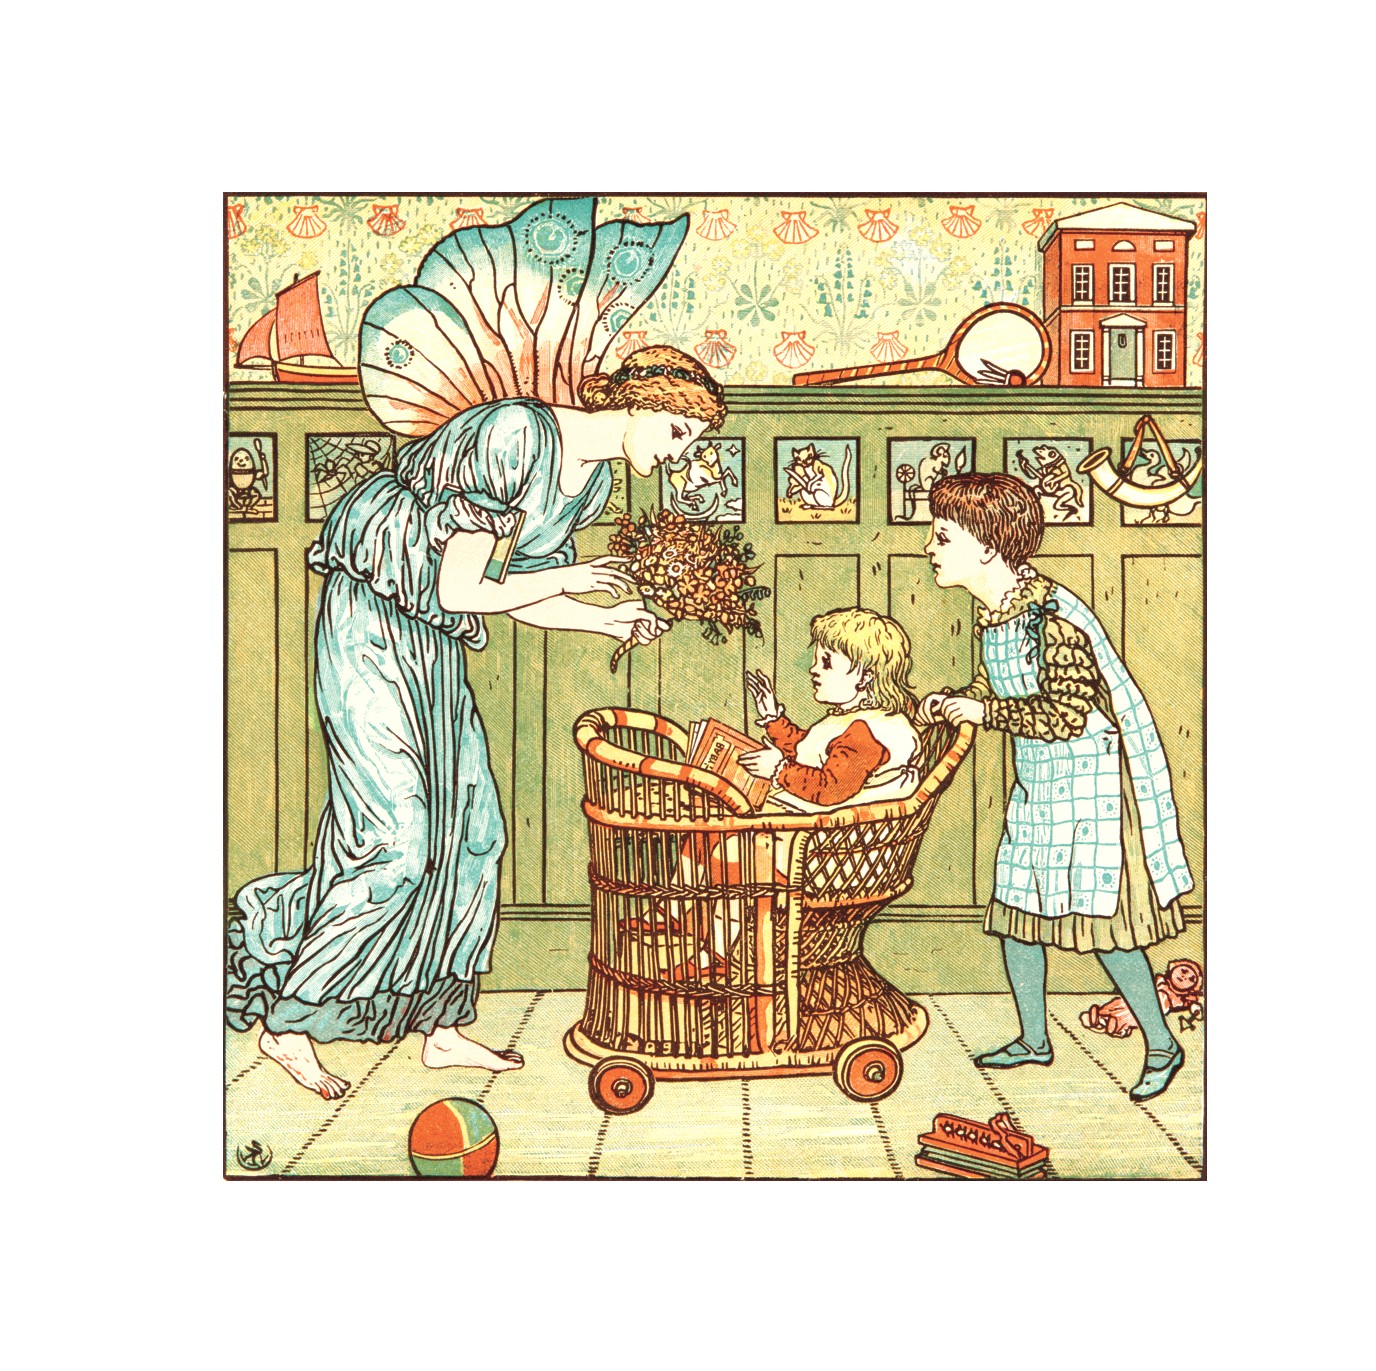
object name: book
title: Walter Crane's Painting Book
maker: walter crane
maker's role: artist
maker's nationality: british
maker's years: 1845-1915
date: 1889-1895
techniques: engraving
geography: england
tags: children,angels